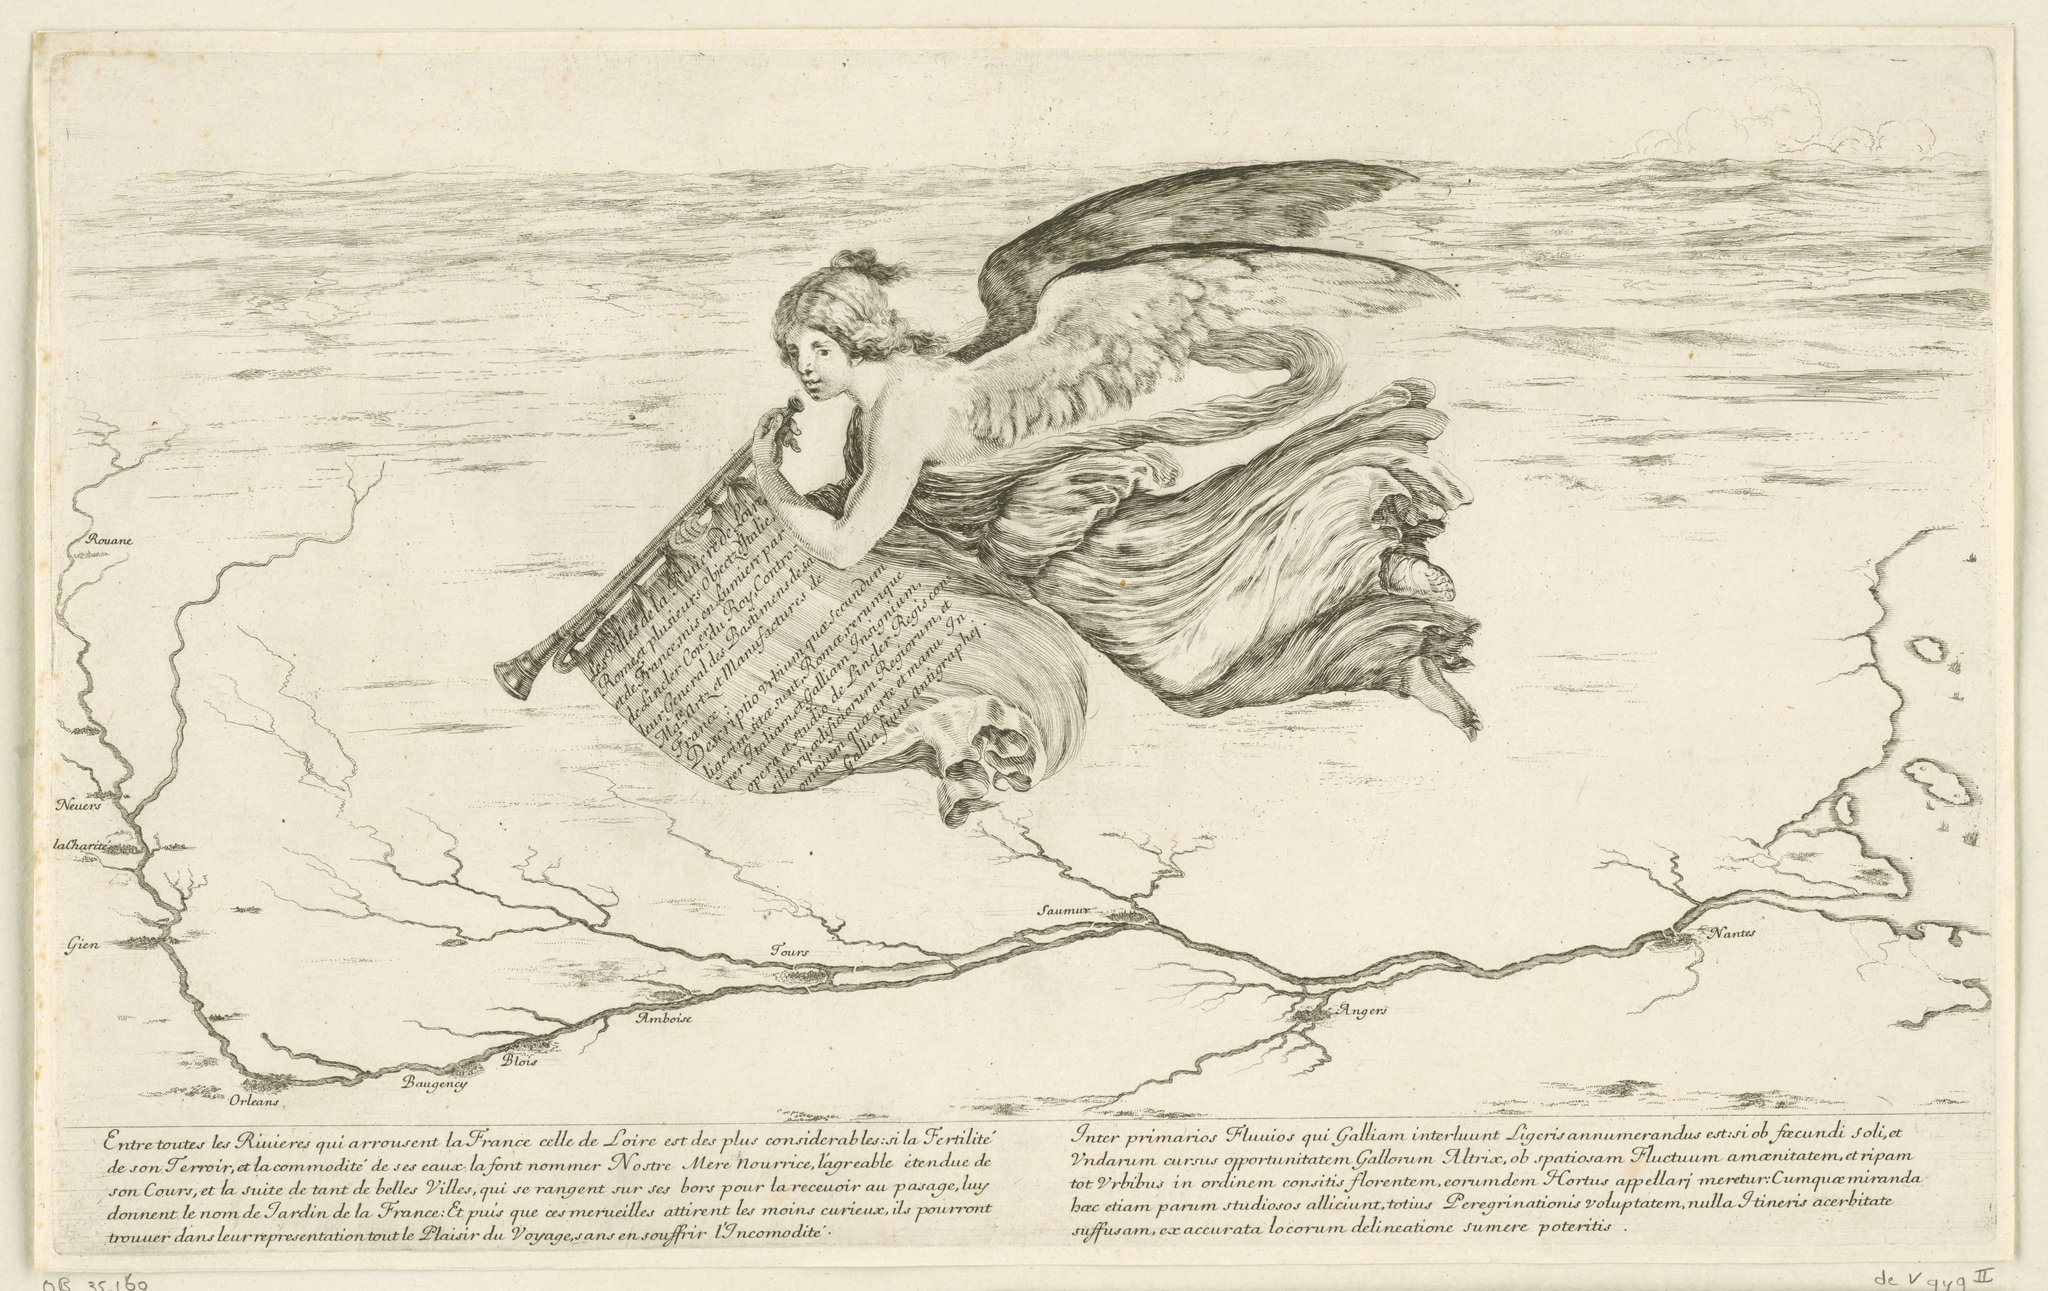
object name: titelprent, frontispice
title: Titelprent met gevleugelde vrouw met trompet zwevend boven Frankrijk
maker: stefano della bella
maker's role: draughtsman, print maker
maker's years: 1610-1664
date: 1620-1664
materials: paper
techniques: etching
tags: maps, atlases, fame; 'fama', 'fama buona', 'fama chiara' (ripa), france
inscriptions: collector's mark: Lugt 240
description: Een gevleugelde vrouw in toga met trompet, vliegend naar links. Aan de trompet hangt een doek met tekst. Ze zweeft boven een kaart van het gebied waar de rivier de Loire stroomt.